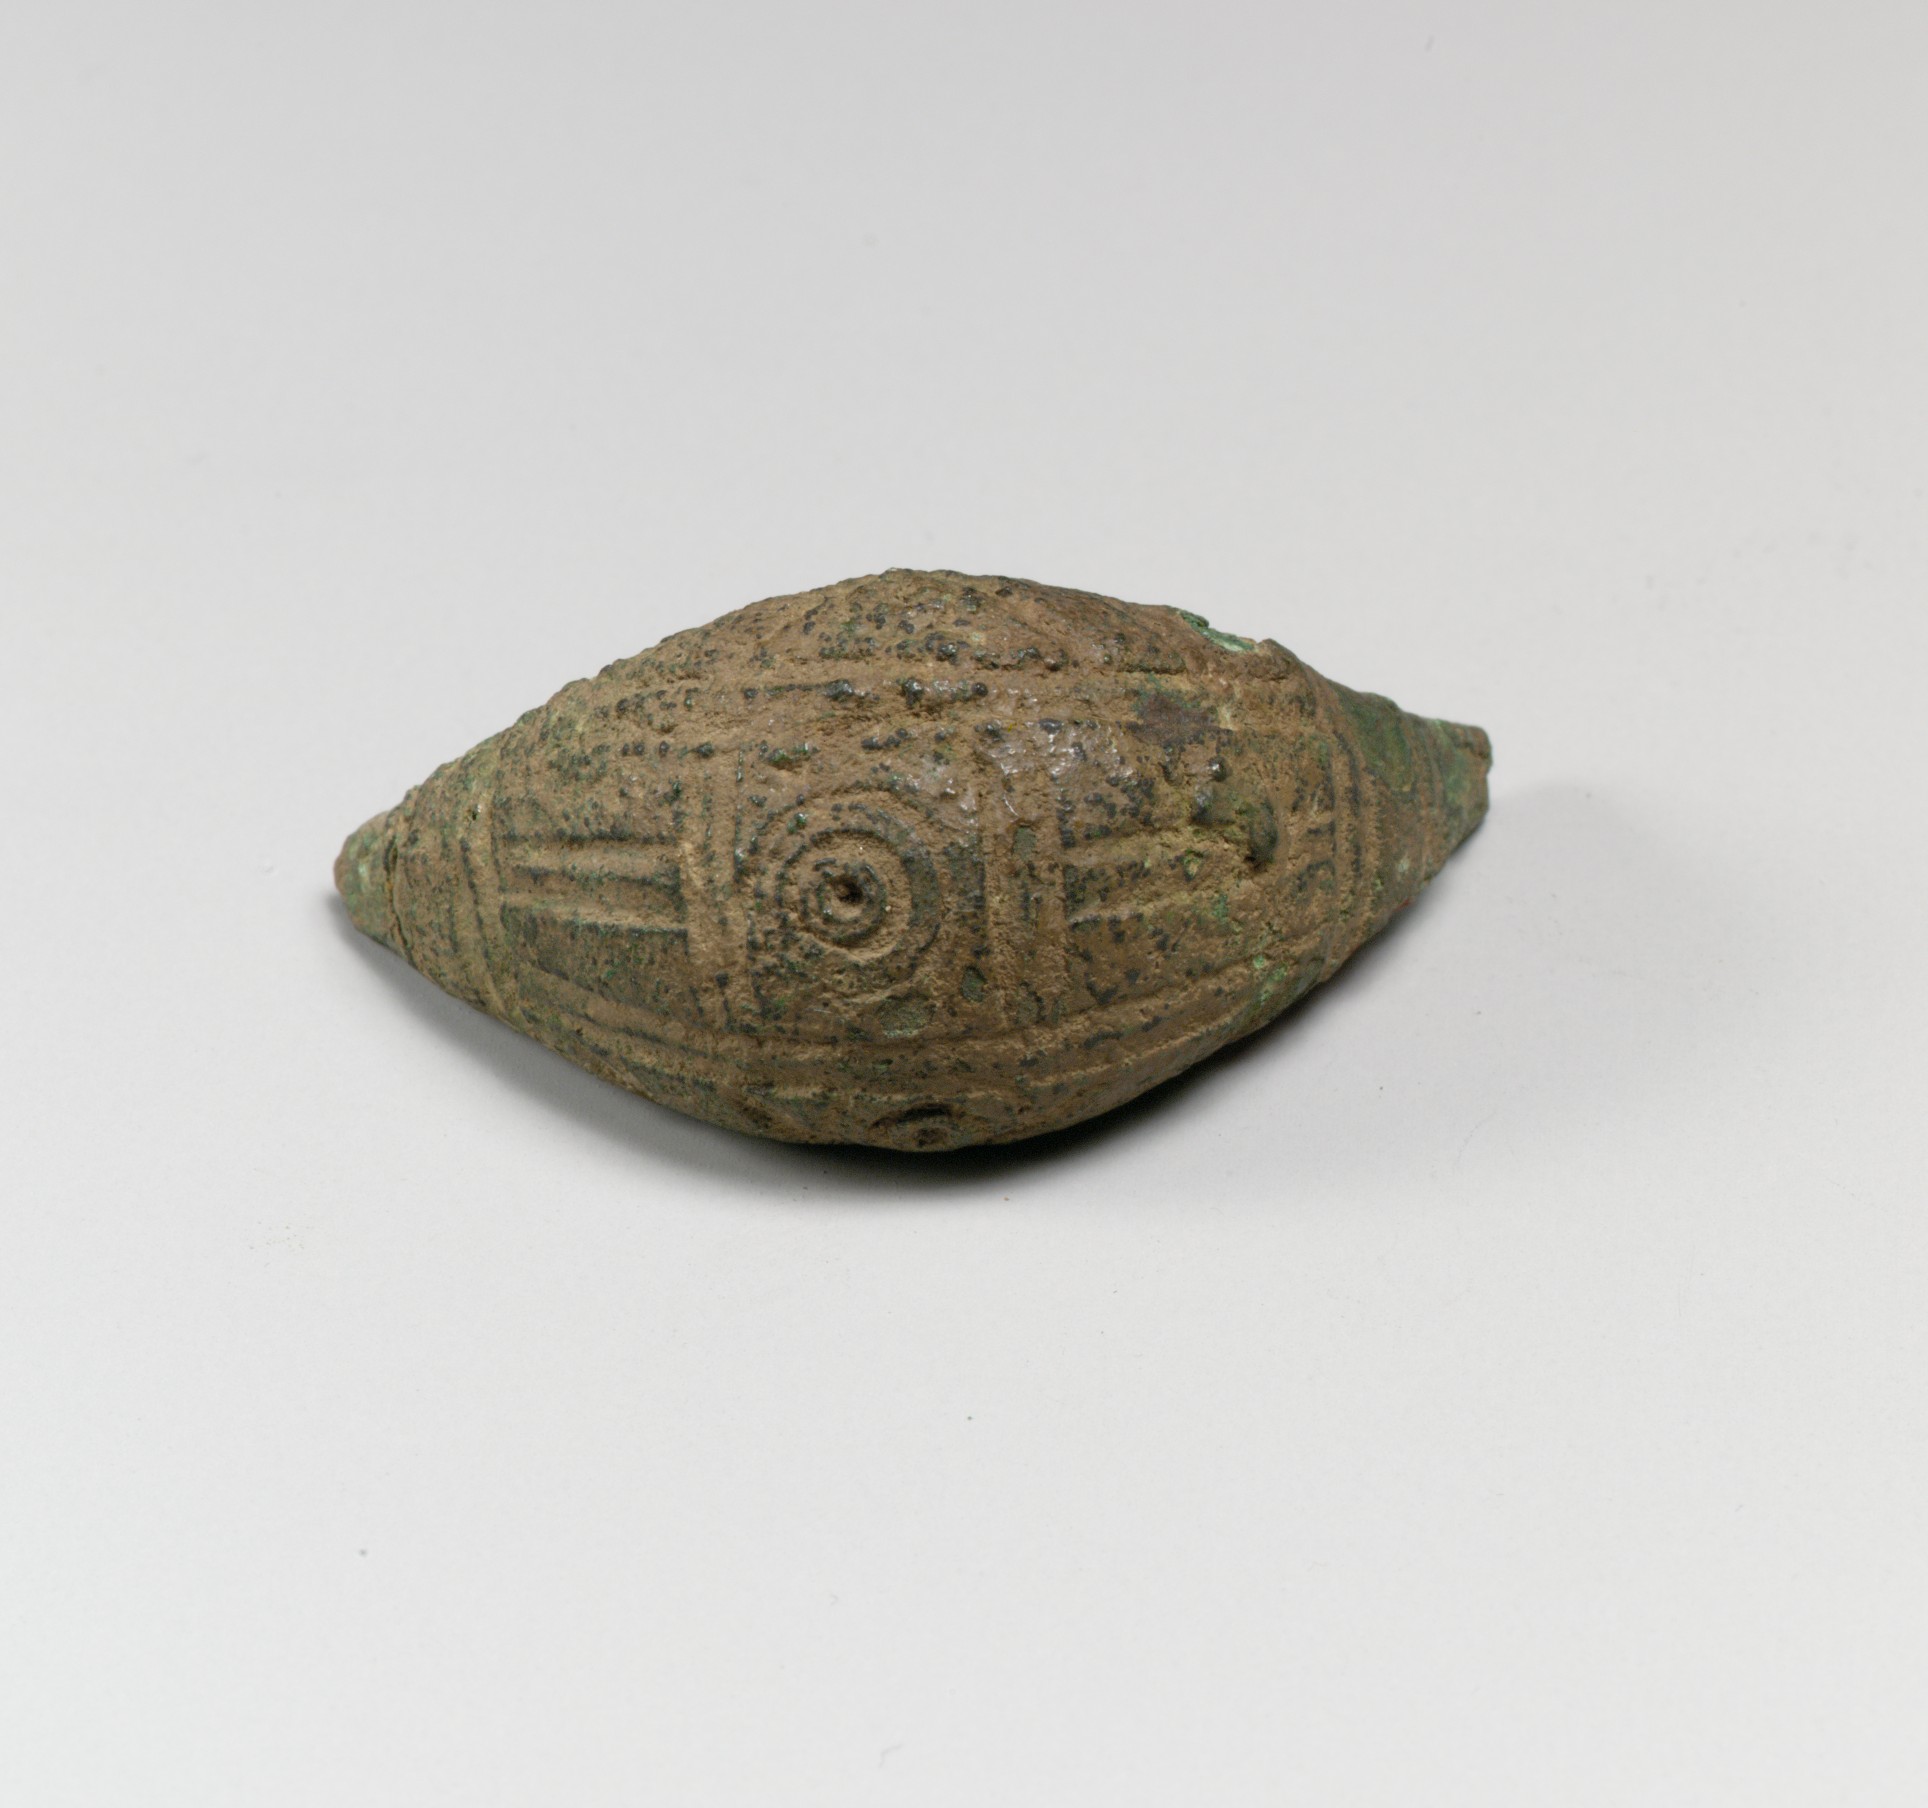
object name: fibula, boat shaped type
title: Fibula, boat-shaped type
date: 800-501 BCE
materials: bronze